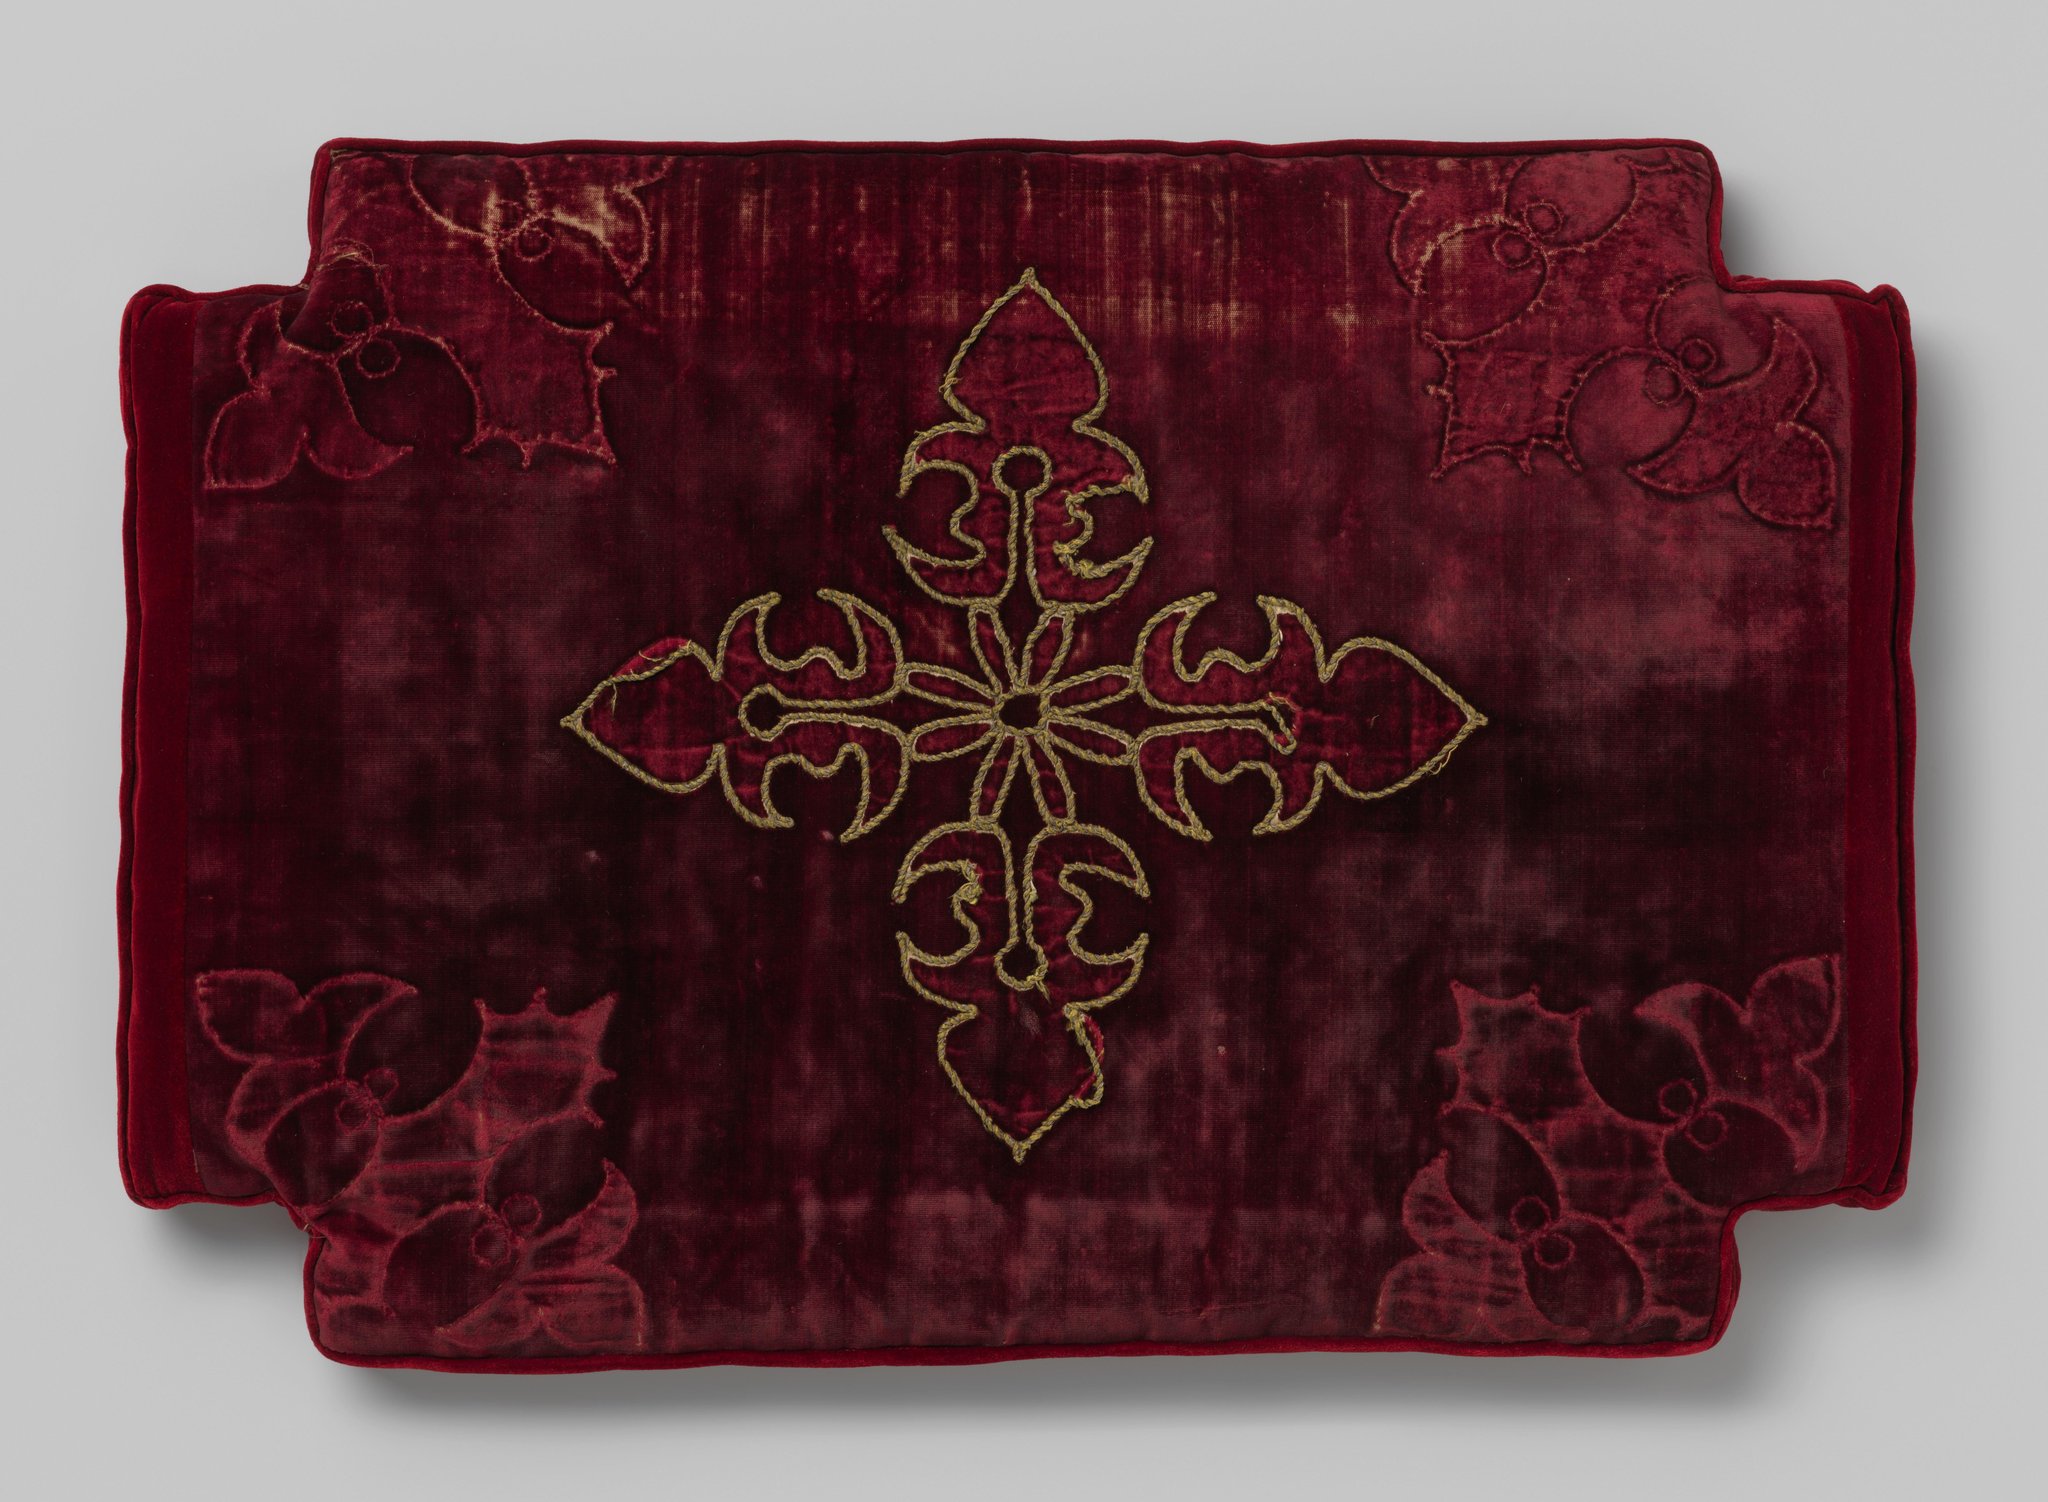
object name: cushion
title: Stoelkussen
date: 1500-1600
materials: textile, velvet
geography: italy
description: Stoelkussen van wijnrood velours, belegd met koord van gouddraad en groene zijde. In het midden een rozet van vier palmetten; in de hoeken twee palmetten ter weerszijden van een overhoeks geplaatste gekartelde stam.